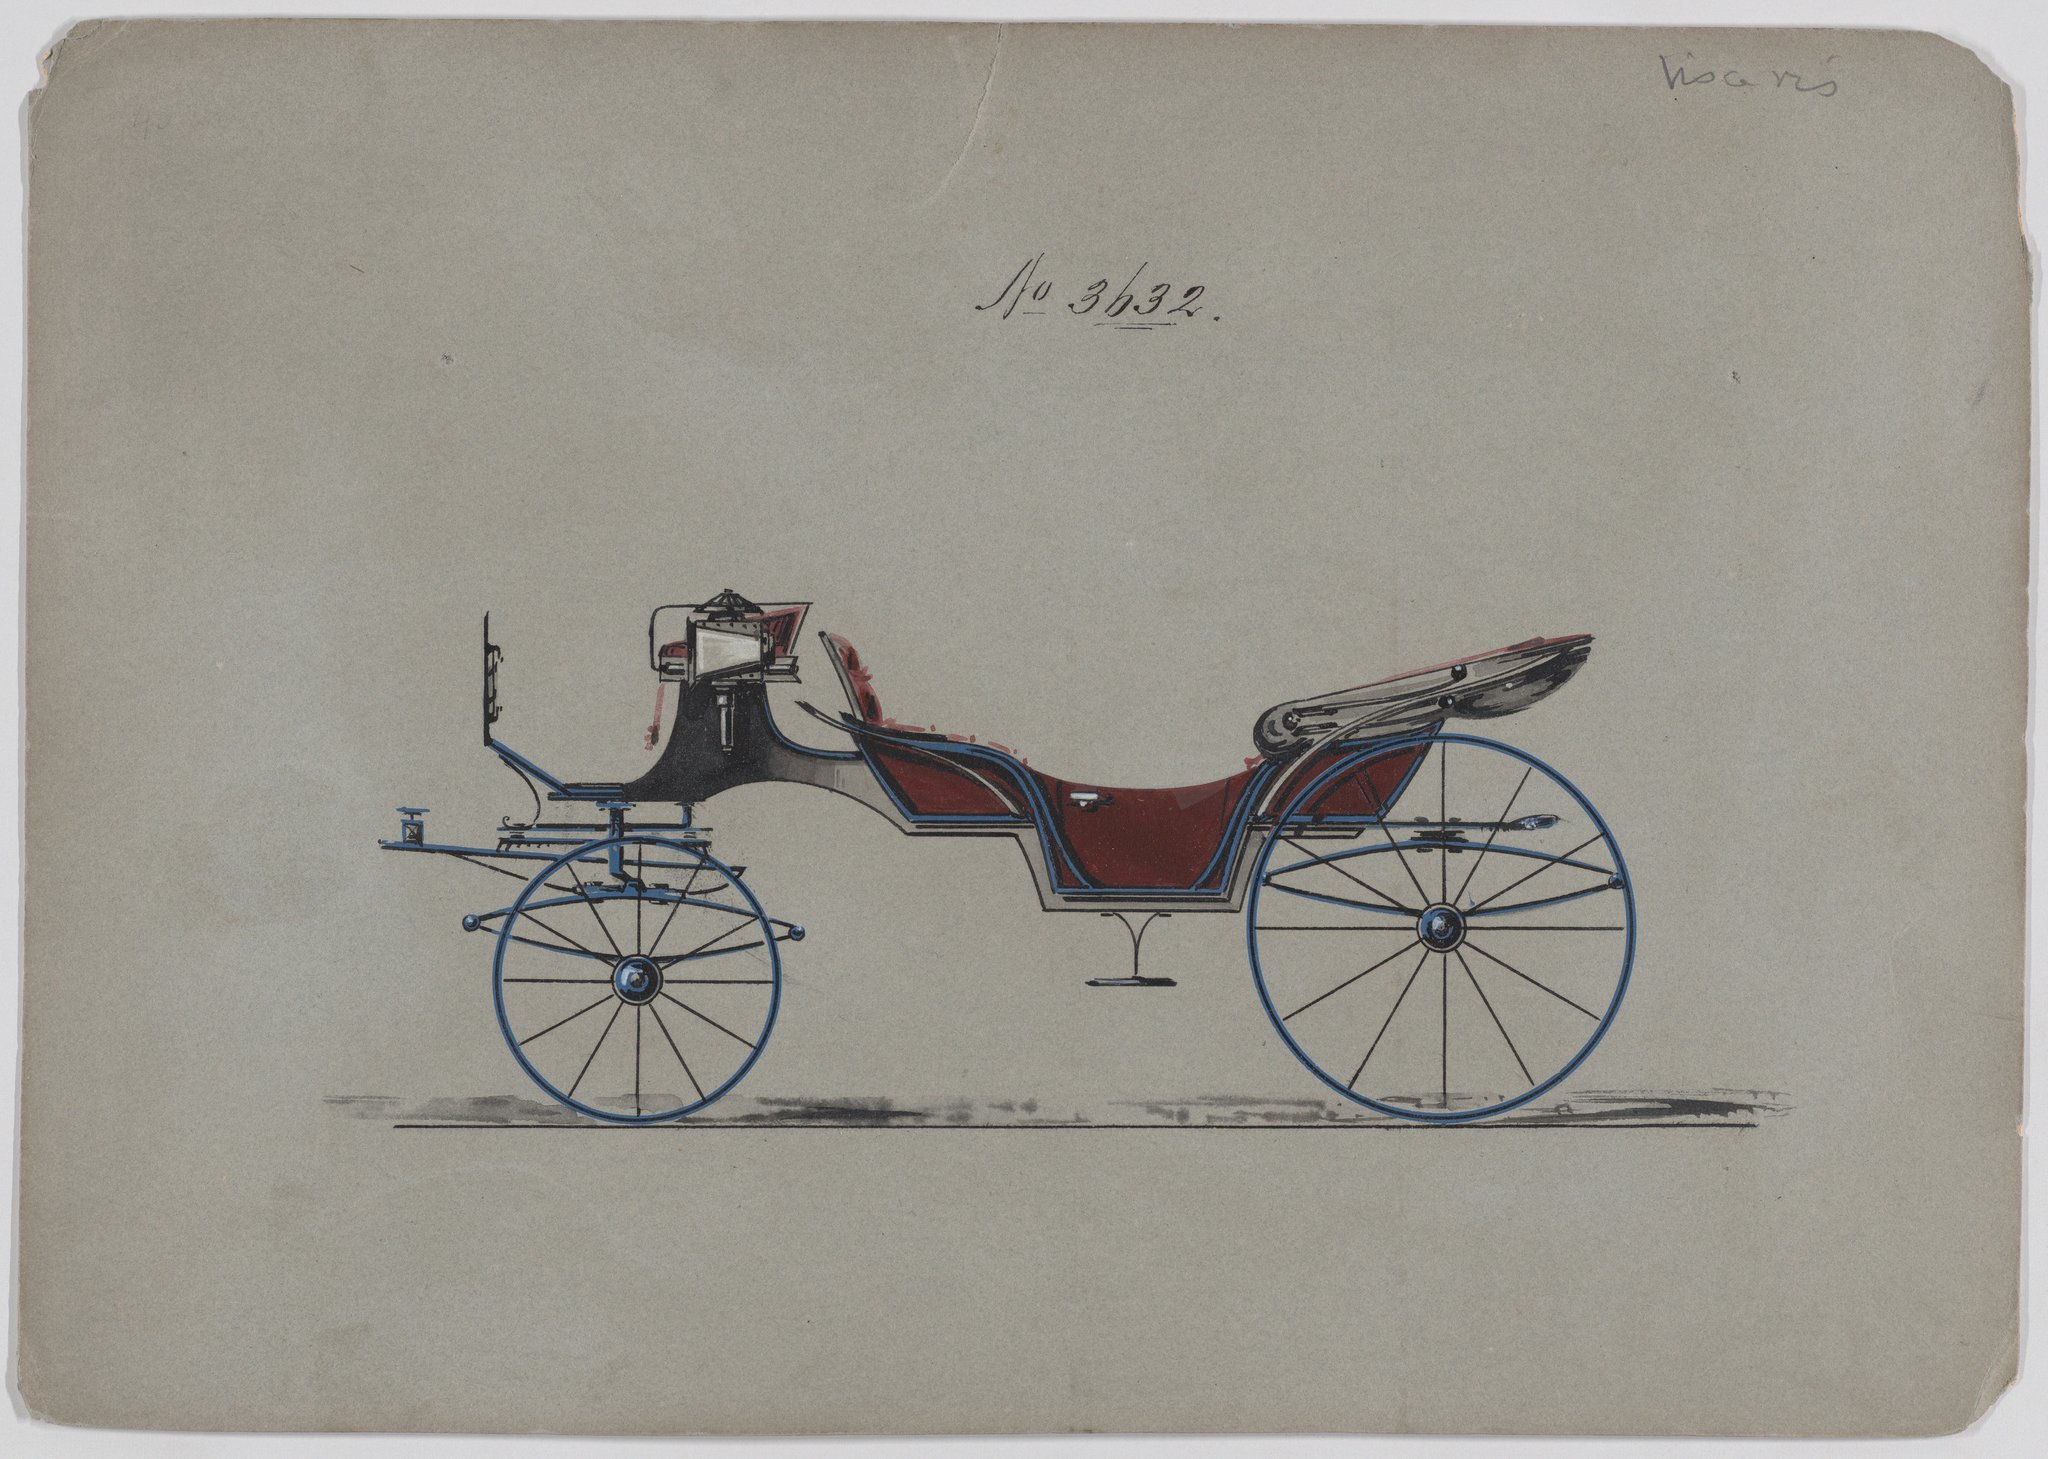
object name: drawing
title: Design for Vis-à-vis, no. 3632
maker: brewster & co.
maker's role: manufacturer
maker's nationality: american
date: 1880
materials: gouache, gum arabic, ink, watercolor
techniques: pen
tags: carriages